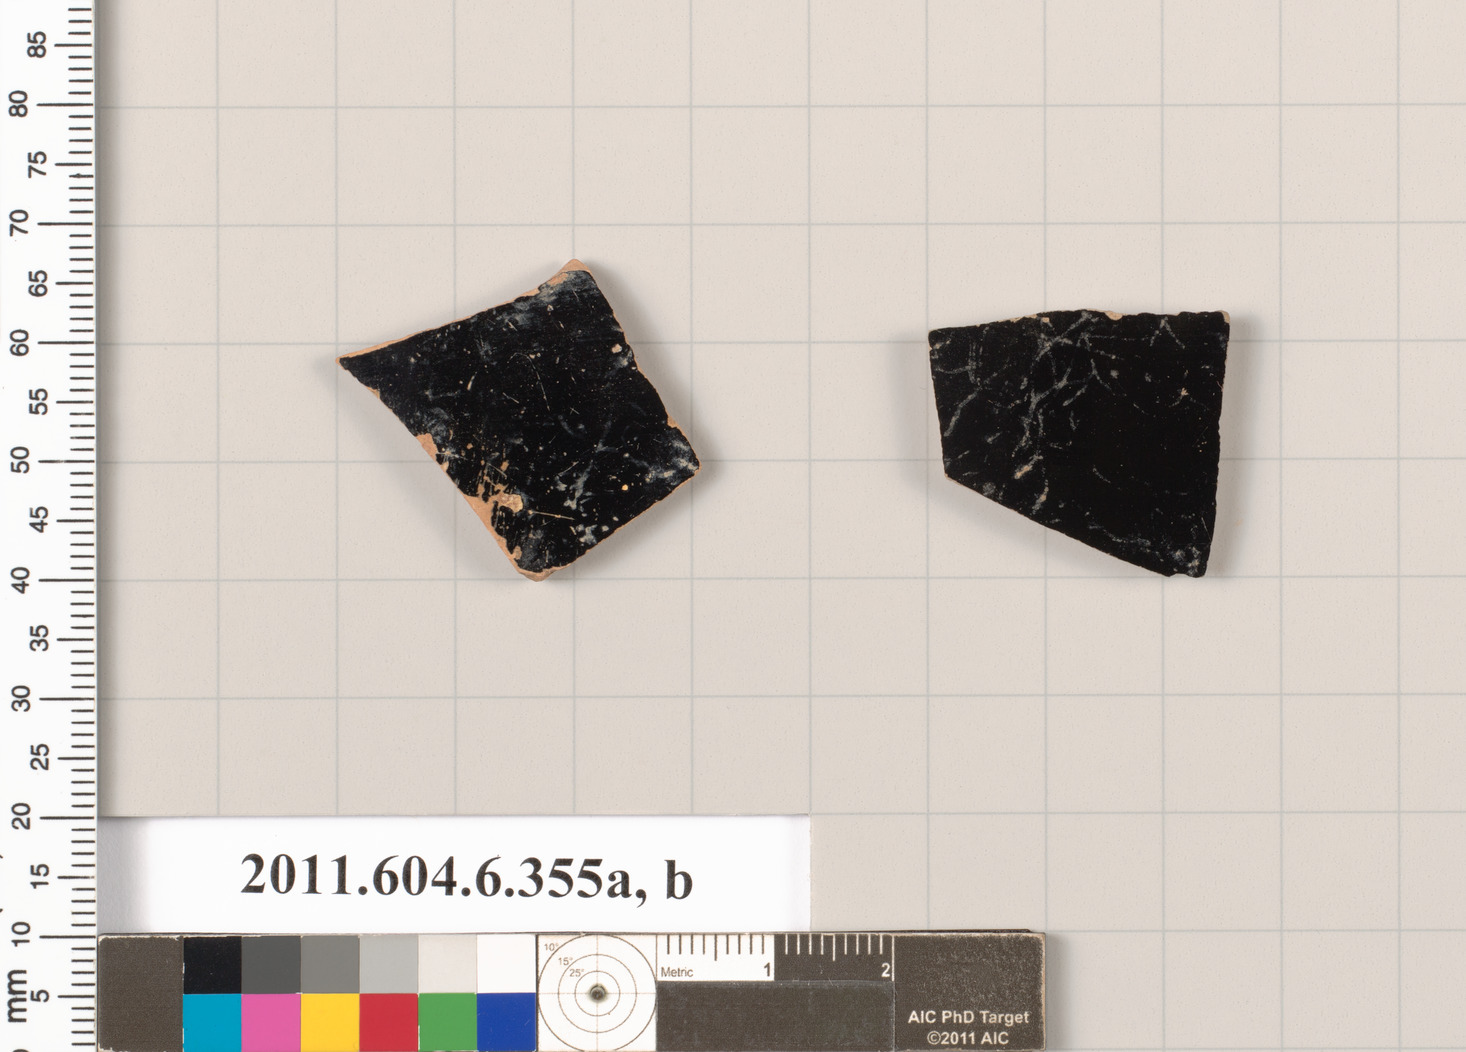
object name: undetermined closed shape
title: Terracotta fragments of closed shapes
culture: greek, attic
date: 600-401 BCE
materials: terracotta